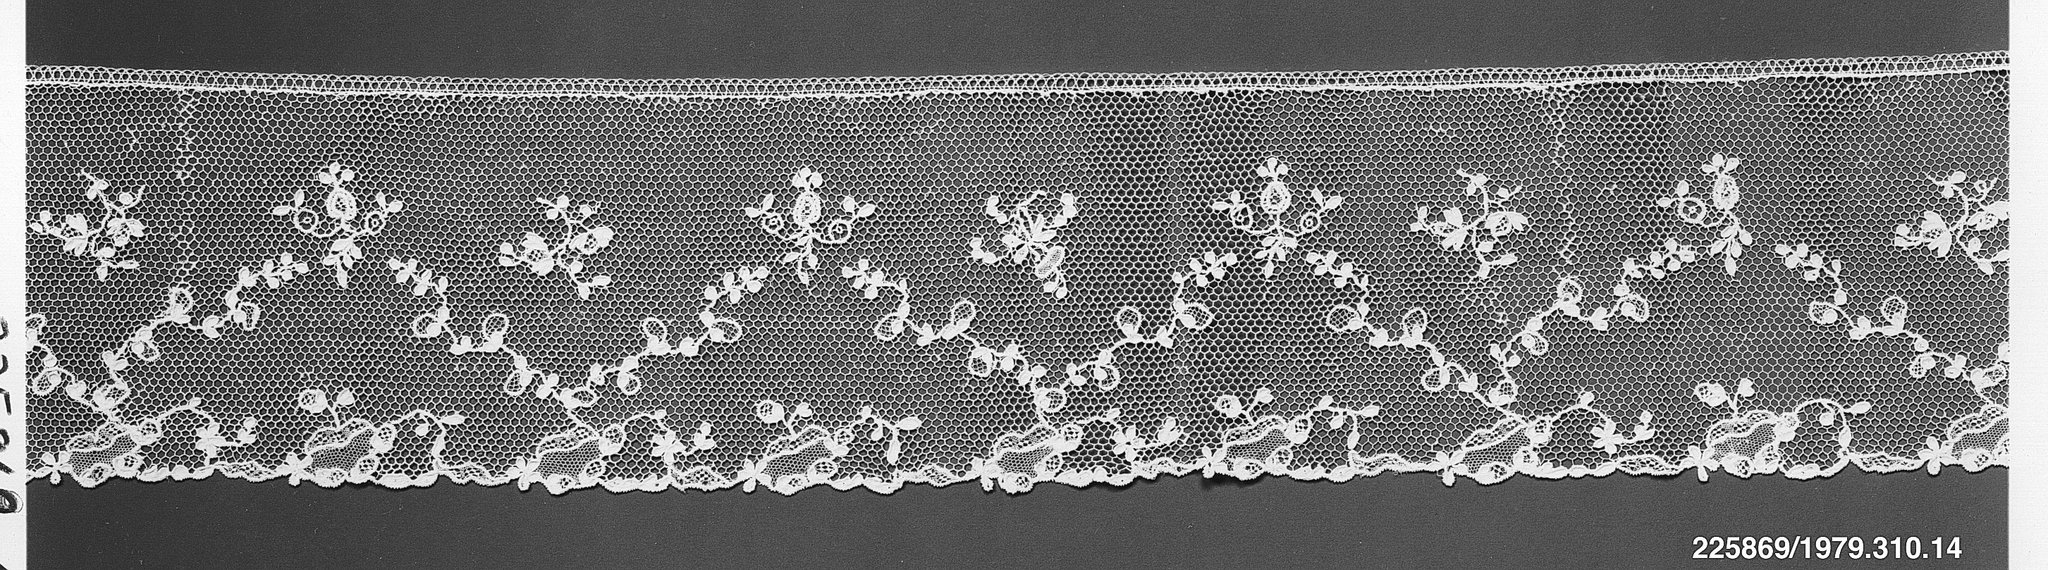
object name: edging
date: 1767-1800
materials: linen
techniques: lace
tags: flowers